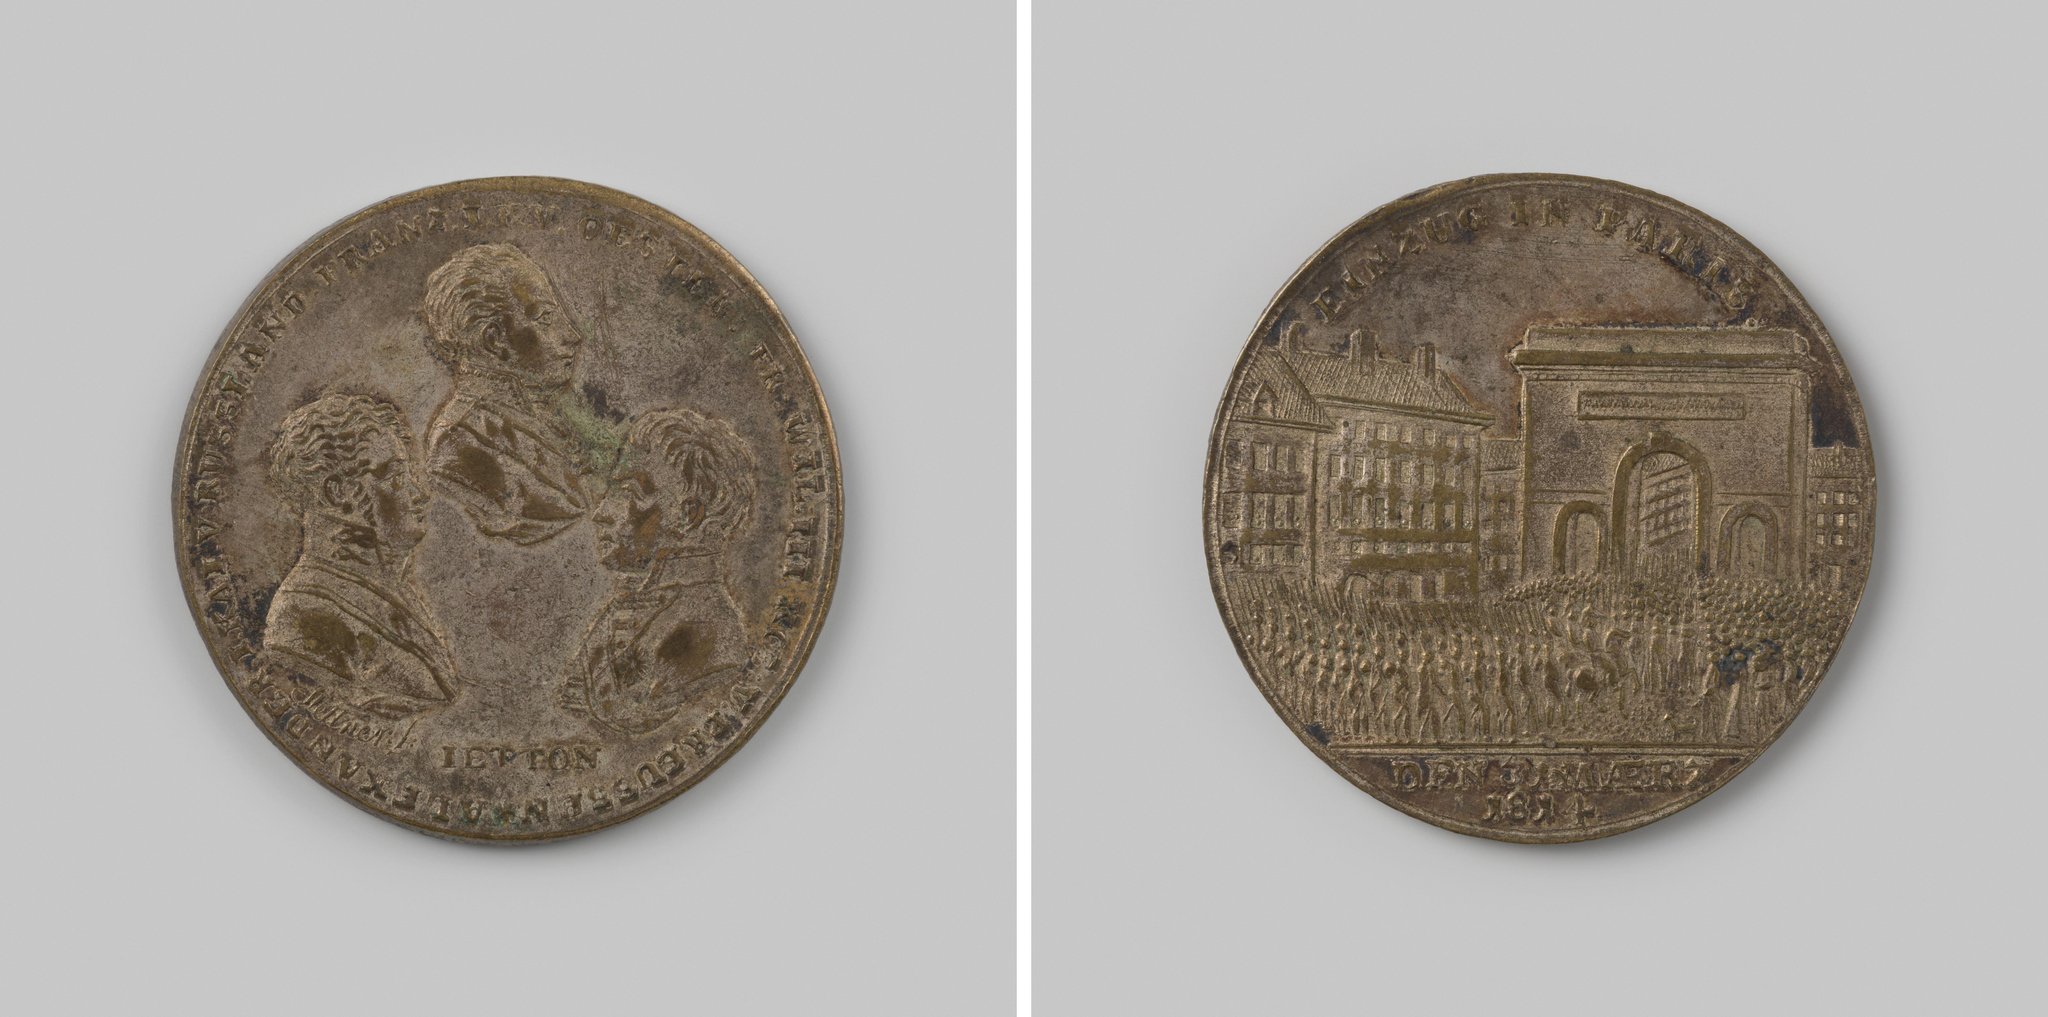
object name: history medal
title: Intocht van de geallieeerden in Parijs 1814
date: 1814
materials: brass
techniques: striking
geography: nuremberg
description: Verzilverd messing penning, op de voorzijde de portretten van Alexander van Rusland, Frans II van Oostenrijk en Frederik Willem III van Pruissen, met omschrift en afsnedetekst, op de keerzijde soldaten marcherend door een triomfpoort, met omschrift en afsnedetekst.